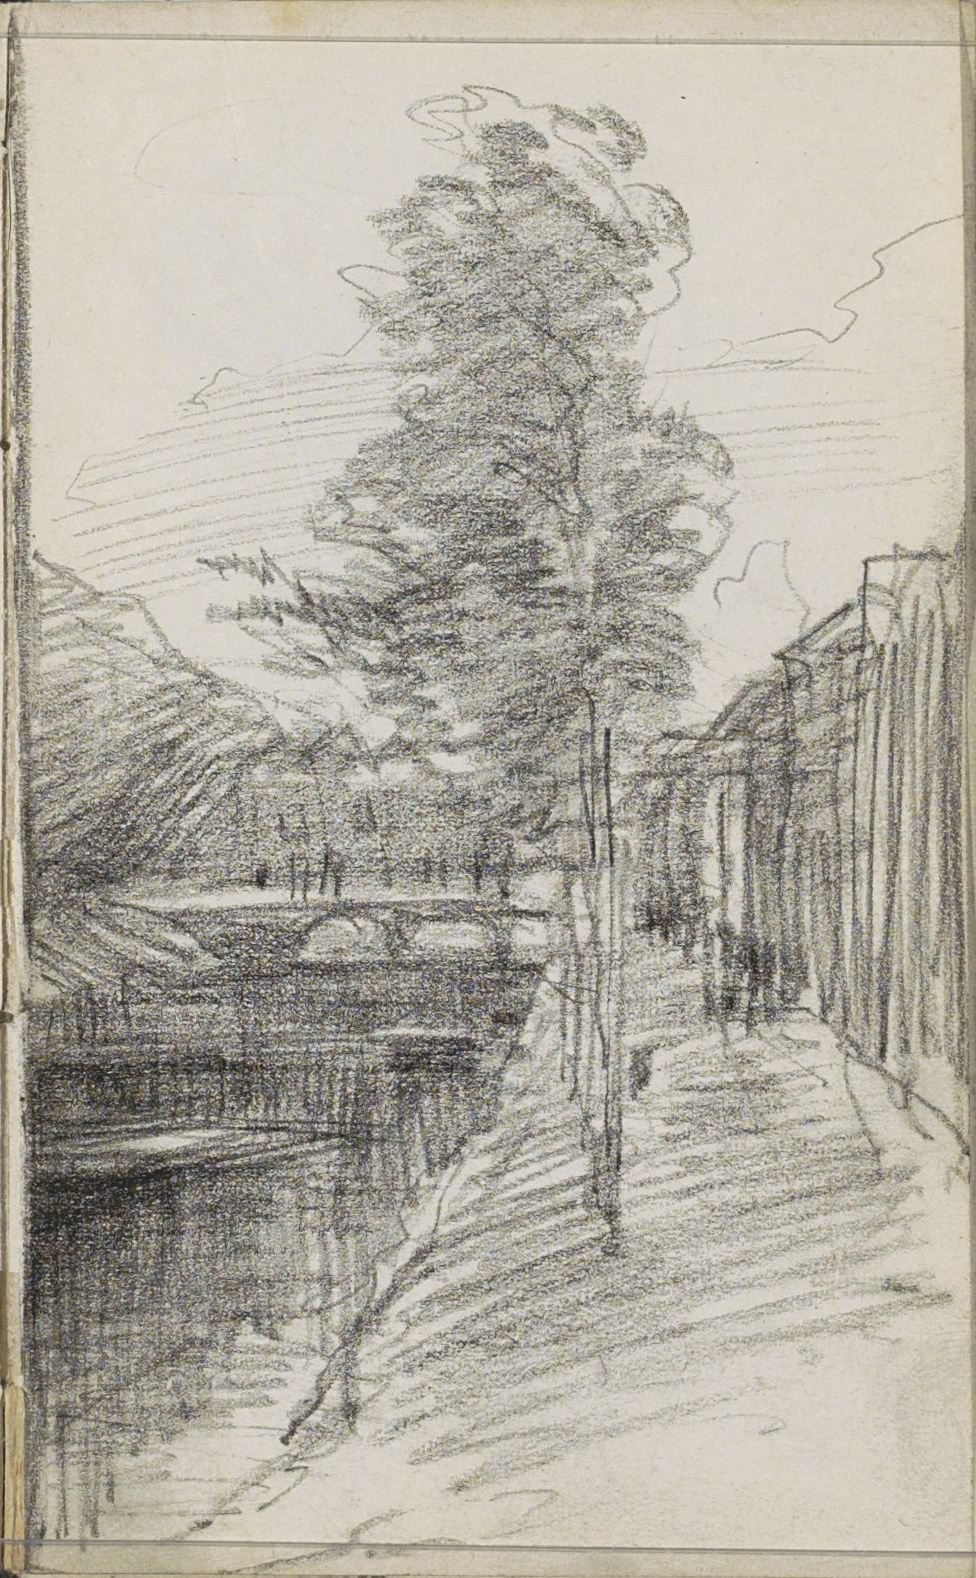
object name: sketchbook leaf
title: Gezicht op de kade langs een kanaal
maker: anton mauve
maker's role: draughtsman, painter, print maker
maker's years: 1838-1888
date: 1848-1888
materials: chalk, paper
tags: canals, waters (in city), bridge in city across river, canal, etc., street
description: In de verte een brug over het kanaal. Blad 11 recto uit een schetsboek met 53 bladen.